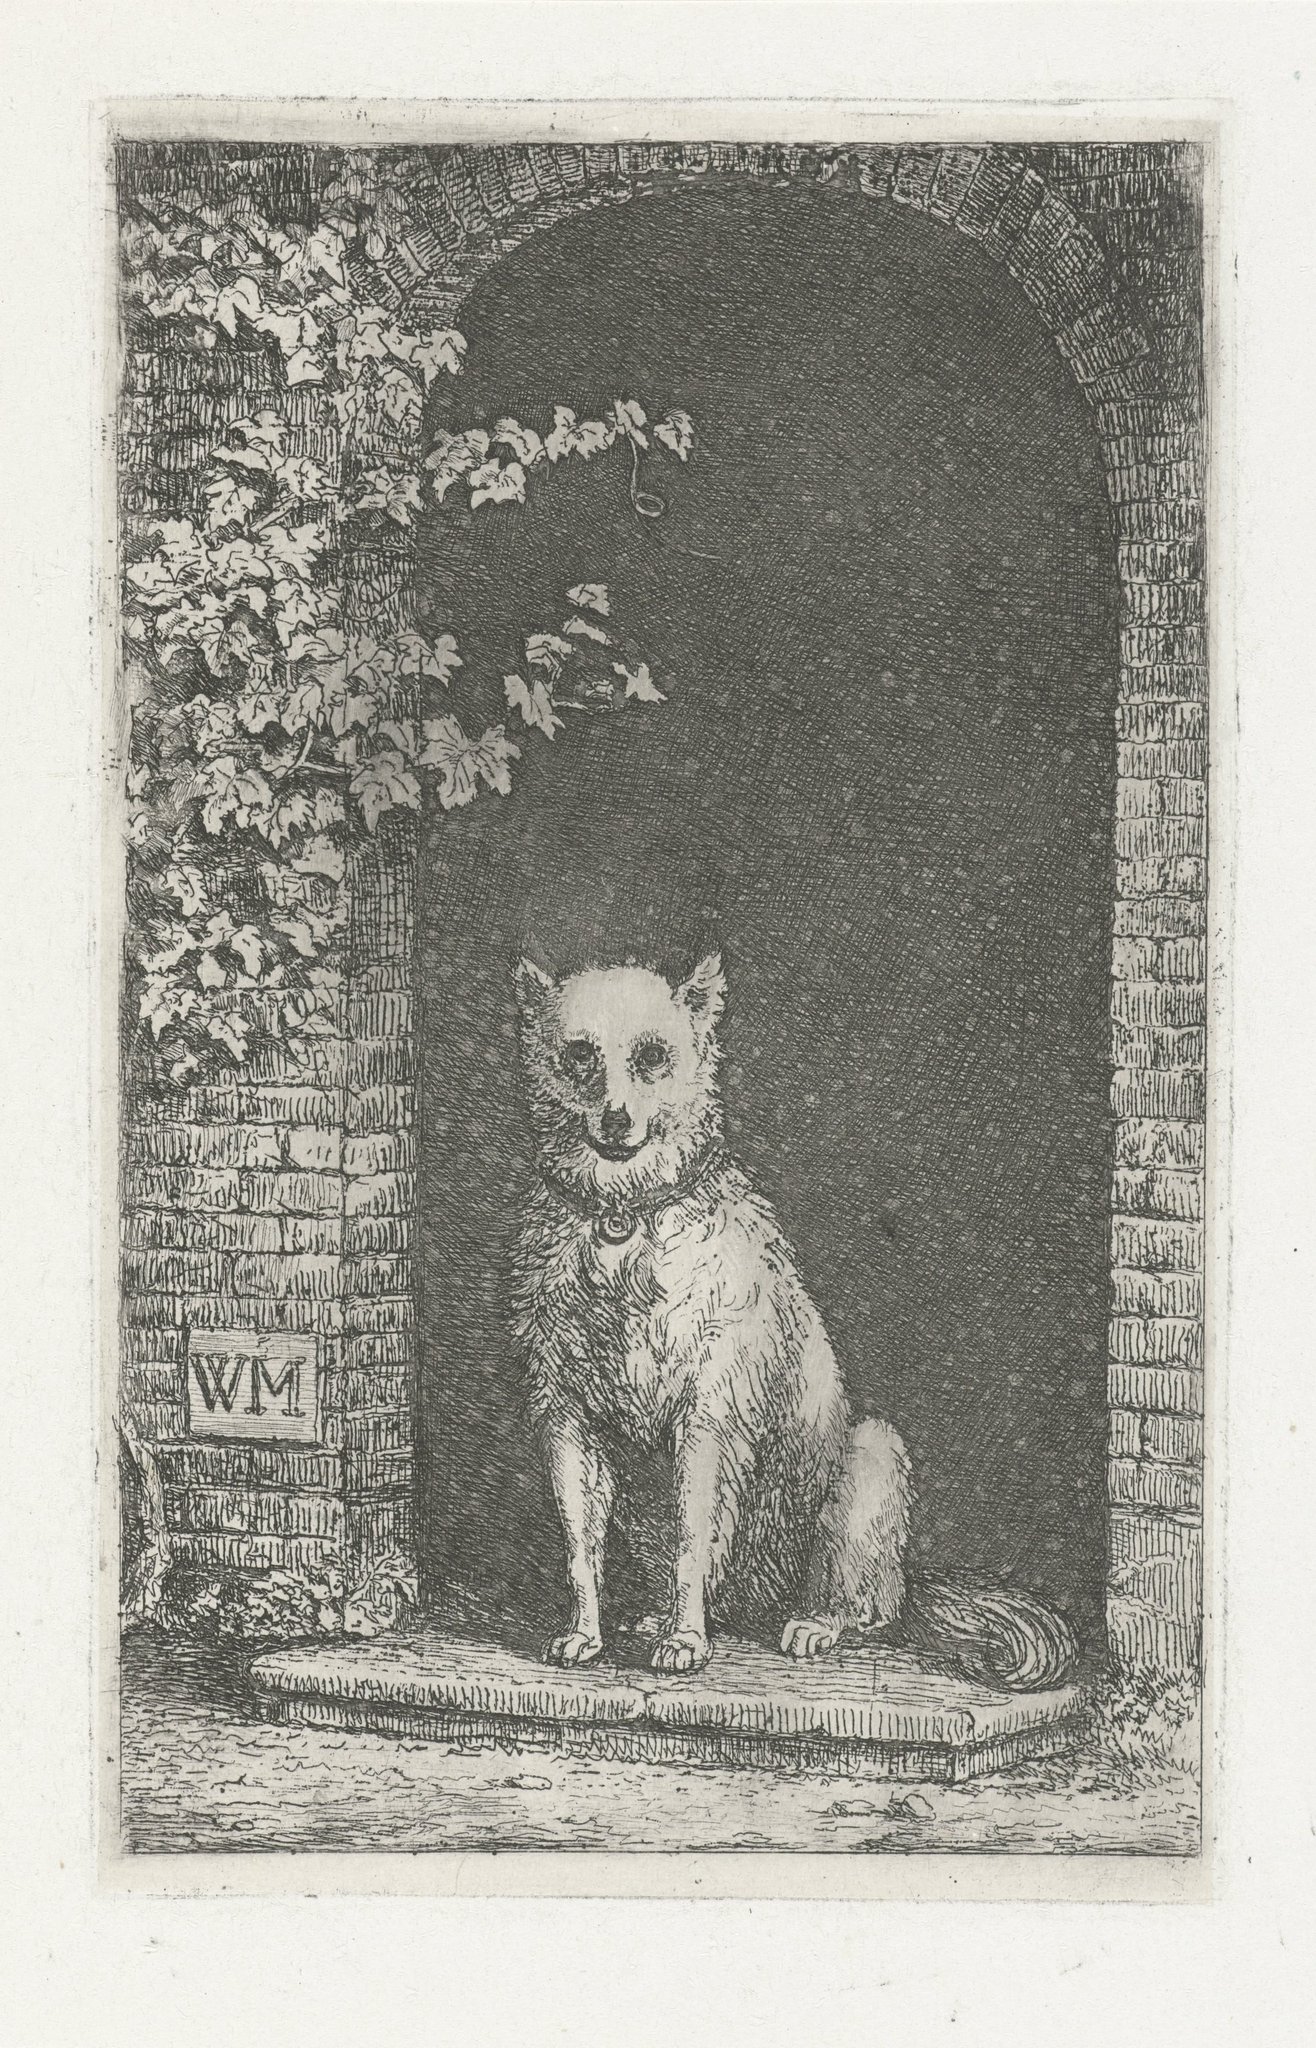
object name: print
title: Op de drempel zittende hond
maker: christiaan wilhelmus moorrees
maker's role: draughtsman, print maker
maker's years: 1801-1867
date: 1811-1867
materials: paper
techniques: etching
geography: netherlands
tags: dog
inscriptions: collector's mark: Lugt 2228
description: Op de drempel van een boogvormige deuropening zit een hond.